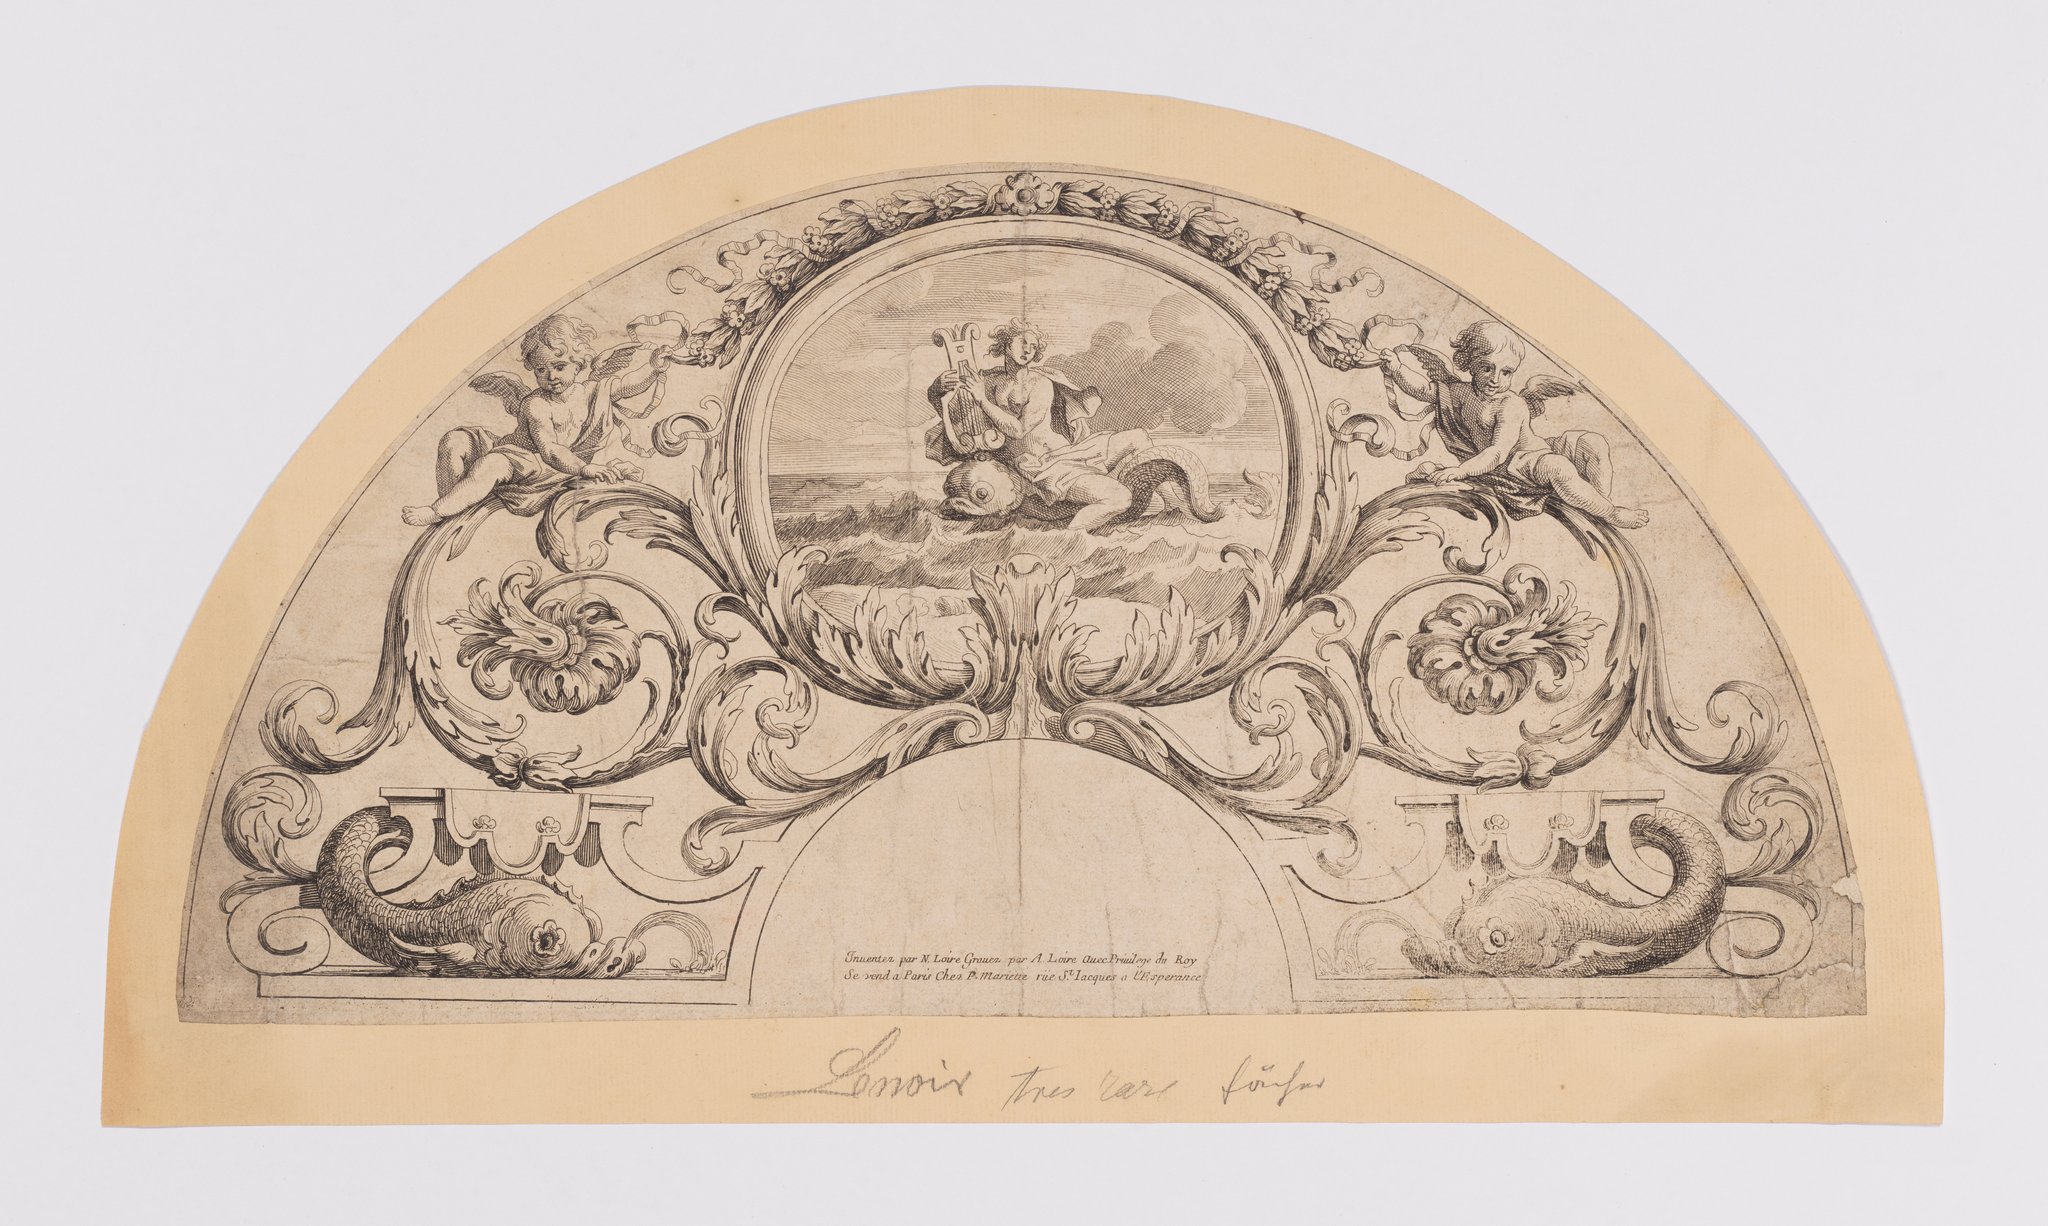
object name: print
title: Fan leaf with acanthus scrolls and dolphins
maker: nicolas loir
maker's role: artist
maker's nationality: french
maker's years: 1624-1679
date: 1601-1700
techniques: etching